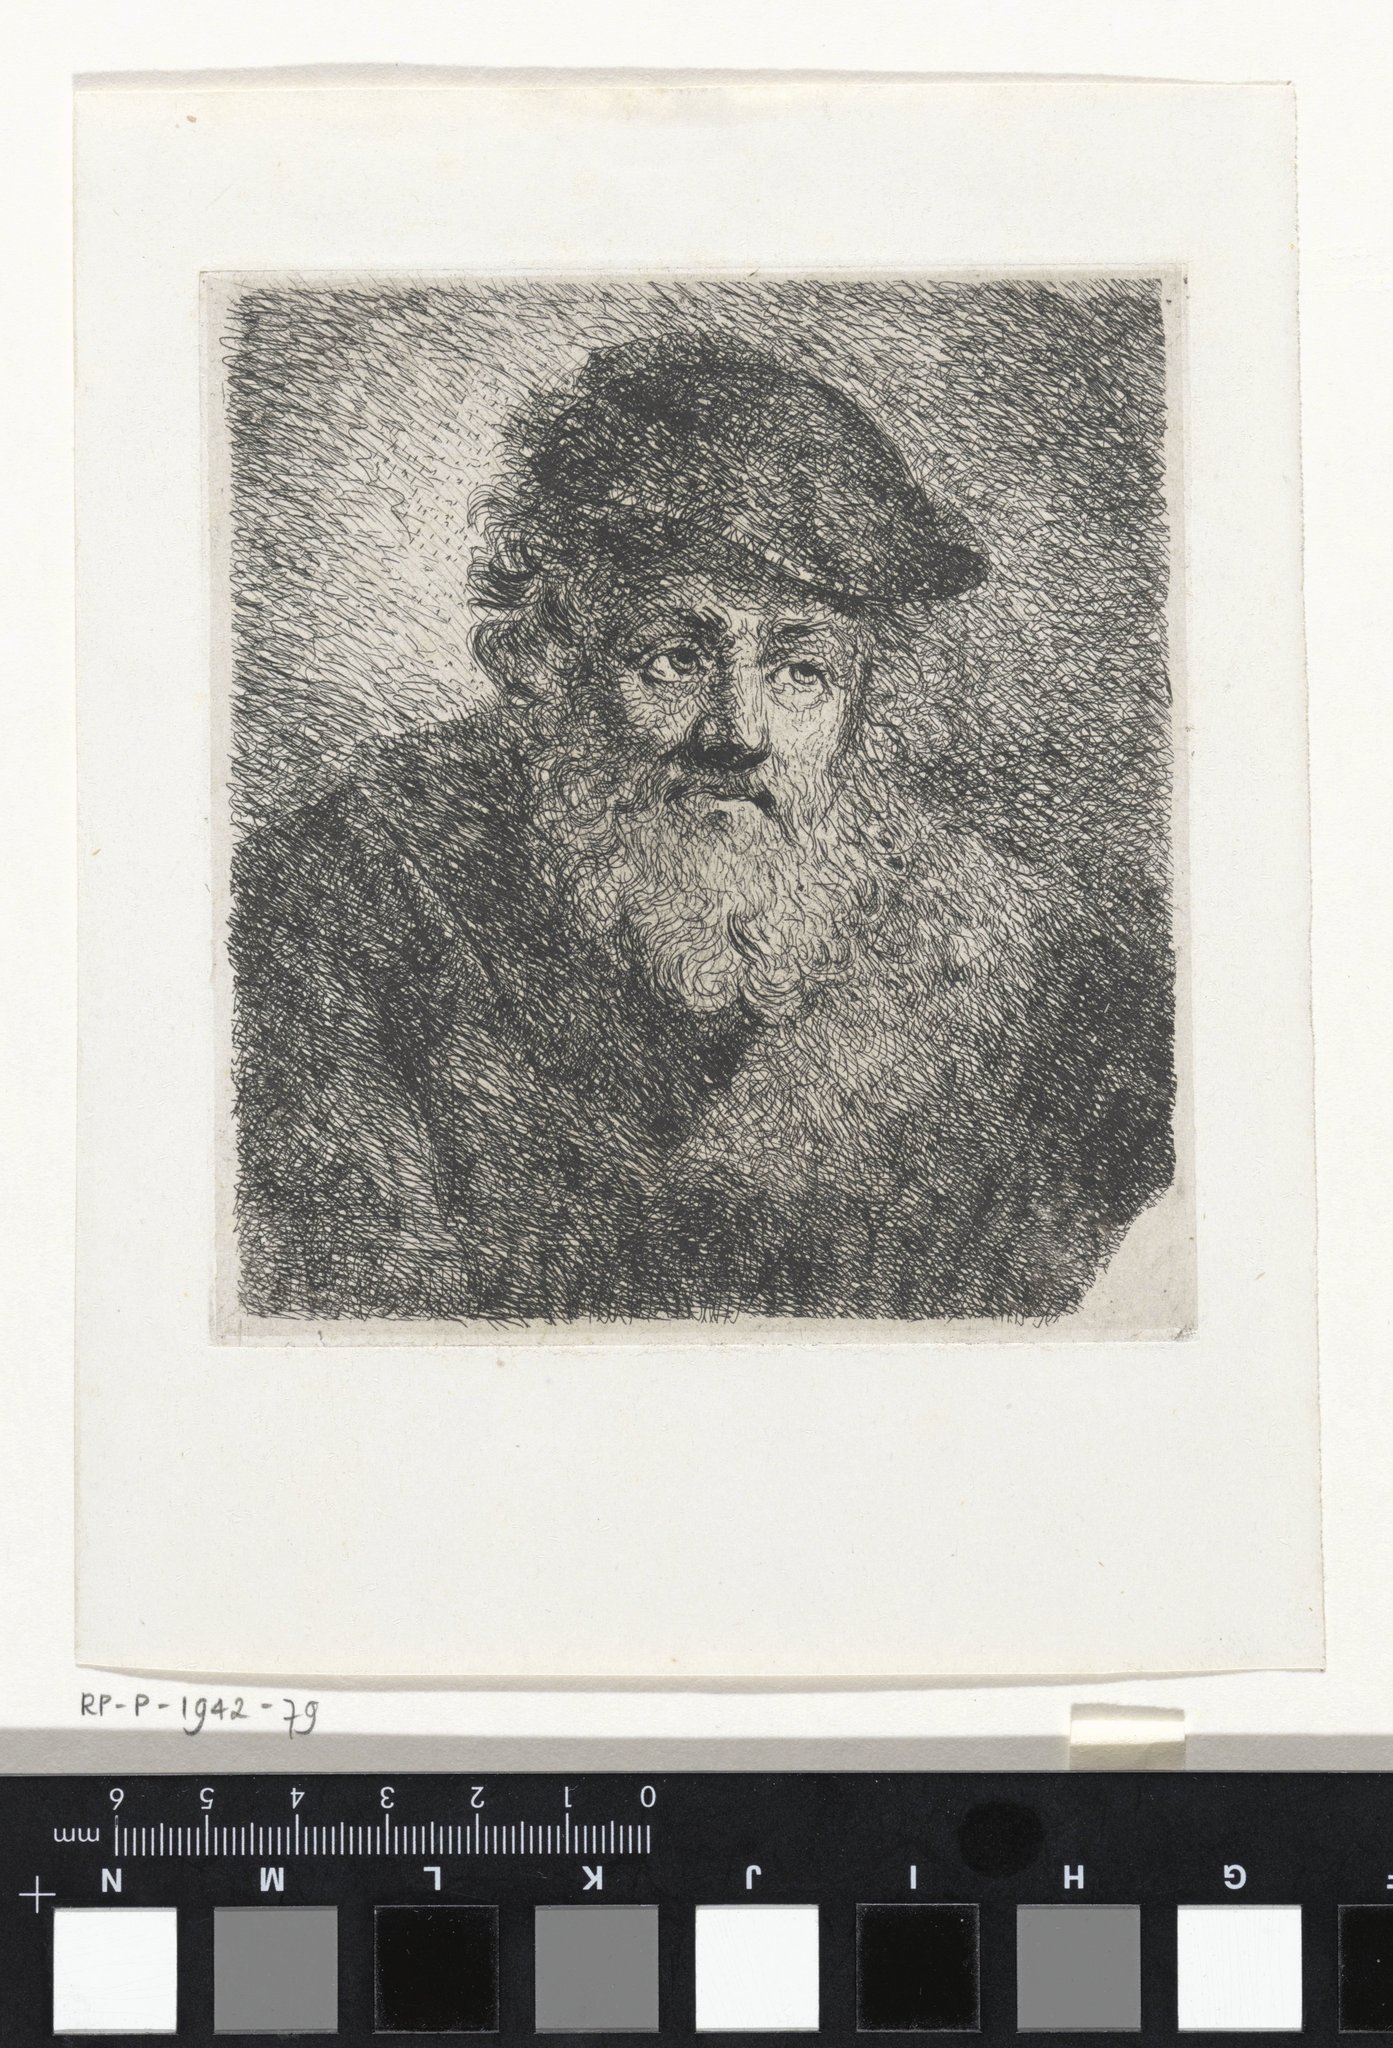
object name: print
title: Oude man met baard en muts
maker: cornelia scheffer-lamme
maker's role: print maker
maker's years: 1769-1839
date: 1784-1839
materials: paper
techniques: etching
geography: northern netherlands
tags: head-gear: cap (+ men's clothes), old man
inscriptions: collector's mark: Lugt 2760, collector's mark: Lugt 2228, collector's mark: Lugt 789a, collector's mark: Lugt 138